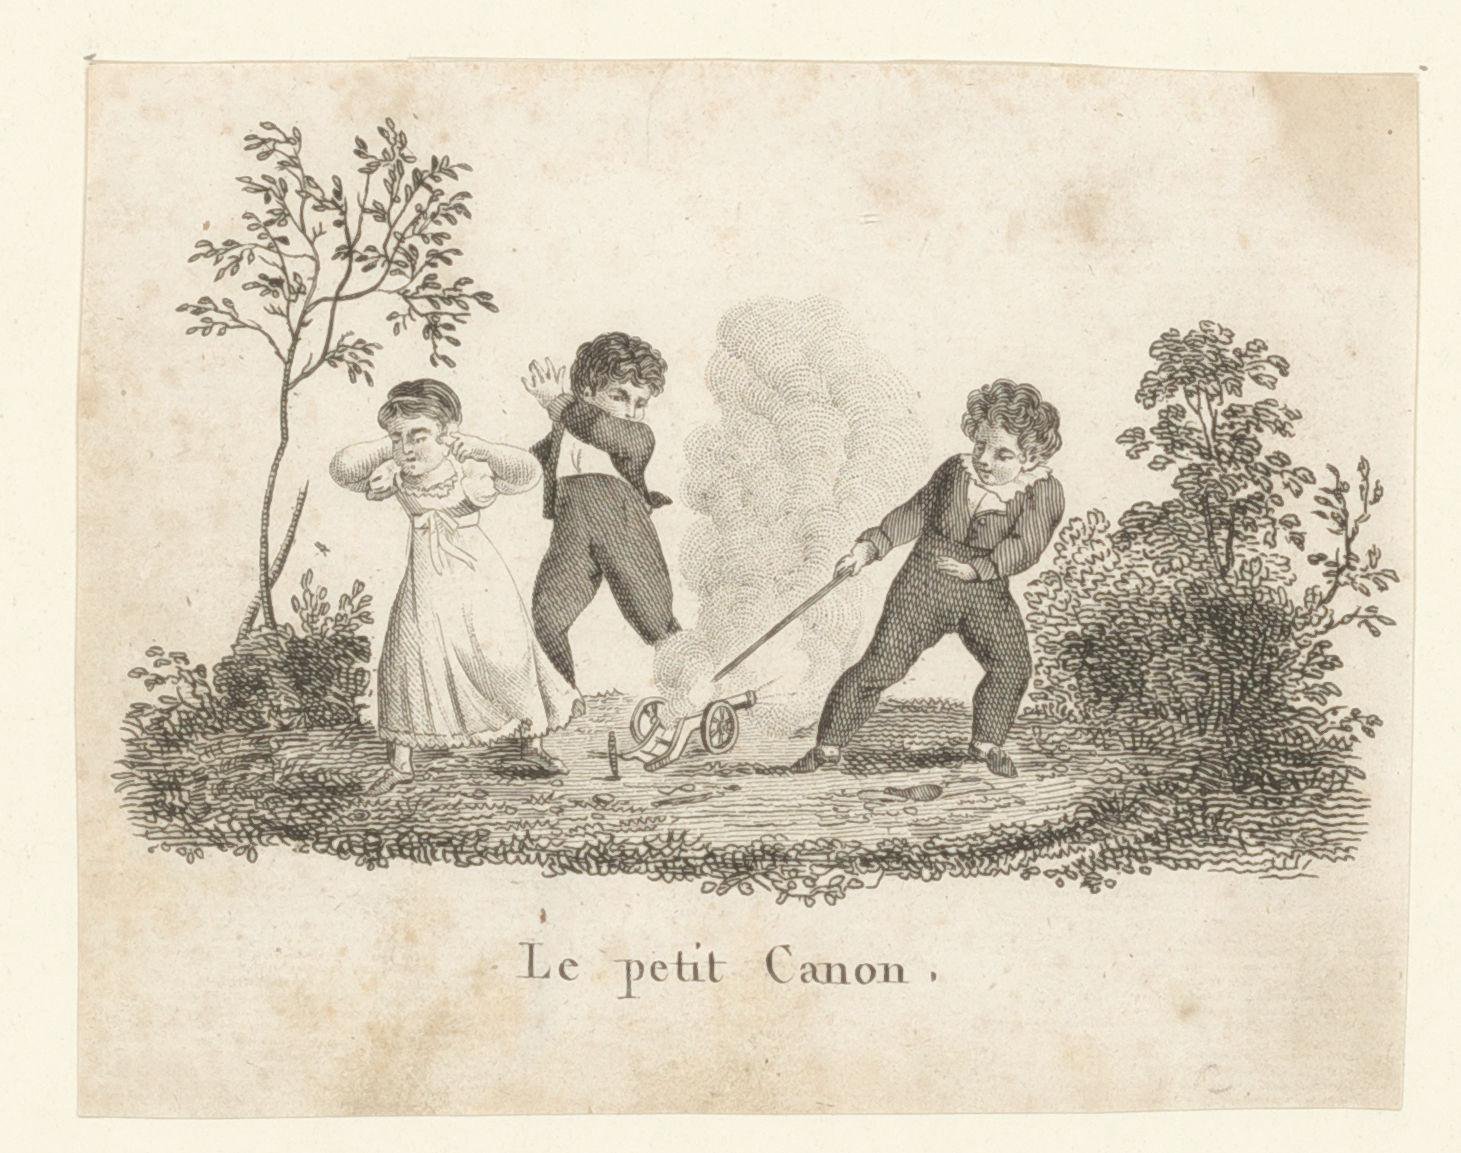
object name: print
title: Le petit Canon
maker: Anonymous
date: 1800-1899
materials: paper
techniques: etching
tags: children's games and plays, firearms: cannon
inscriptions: collector's mark: Lugt 1641, stamp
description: Onderwerpsrubrieken binnen de Atlas Zeden en Gewoonten: Zeden en Gewoonten in Engeren Zin, Des menschen beging, midden en einde, Kinderleven – Kinderspel en Kinderprenten.